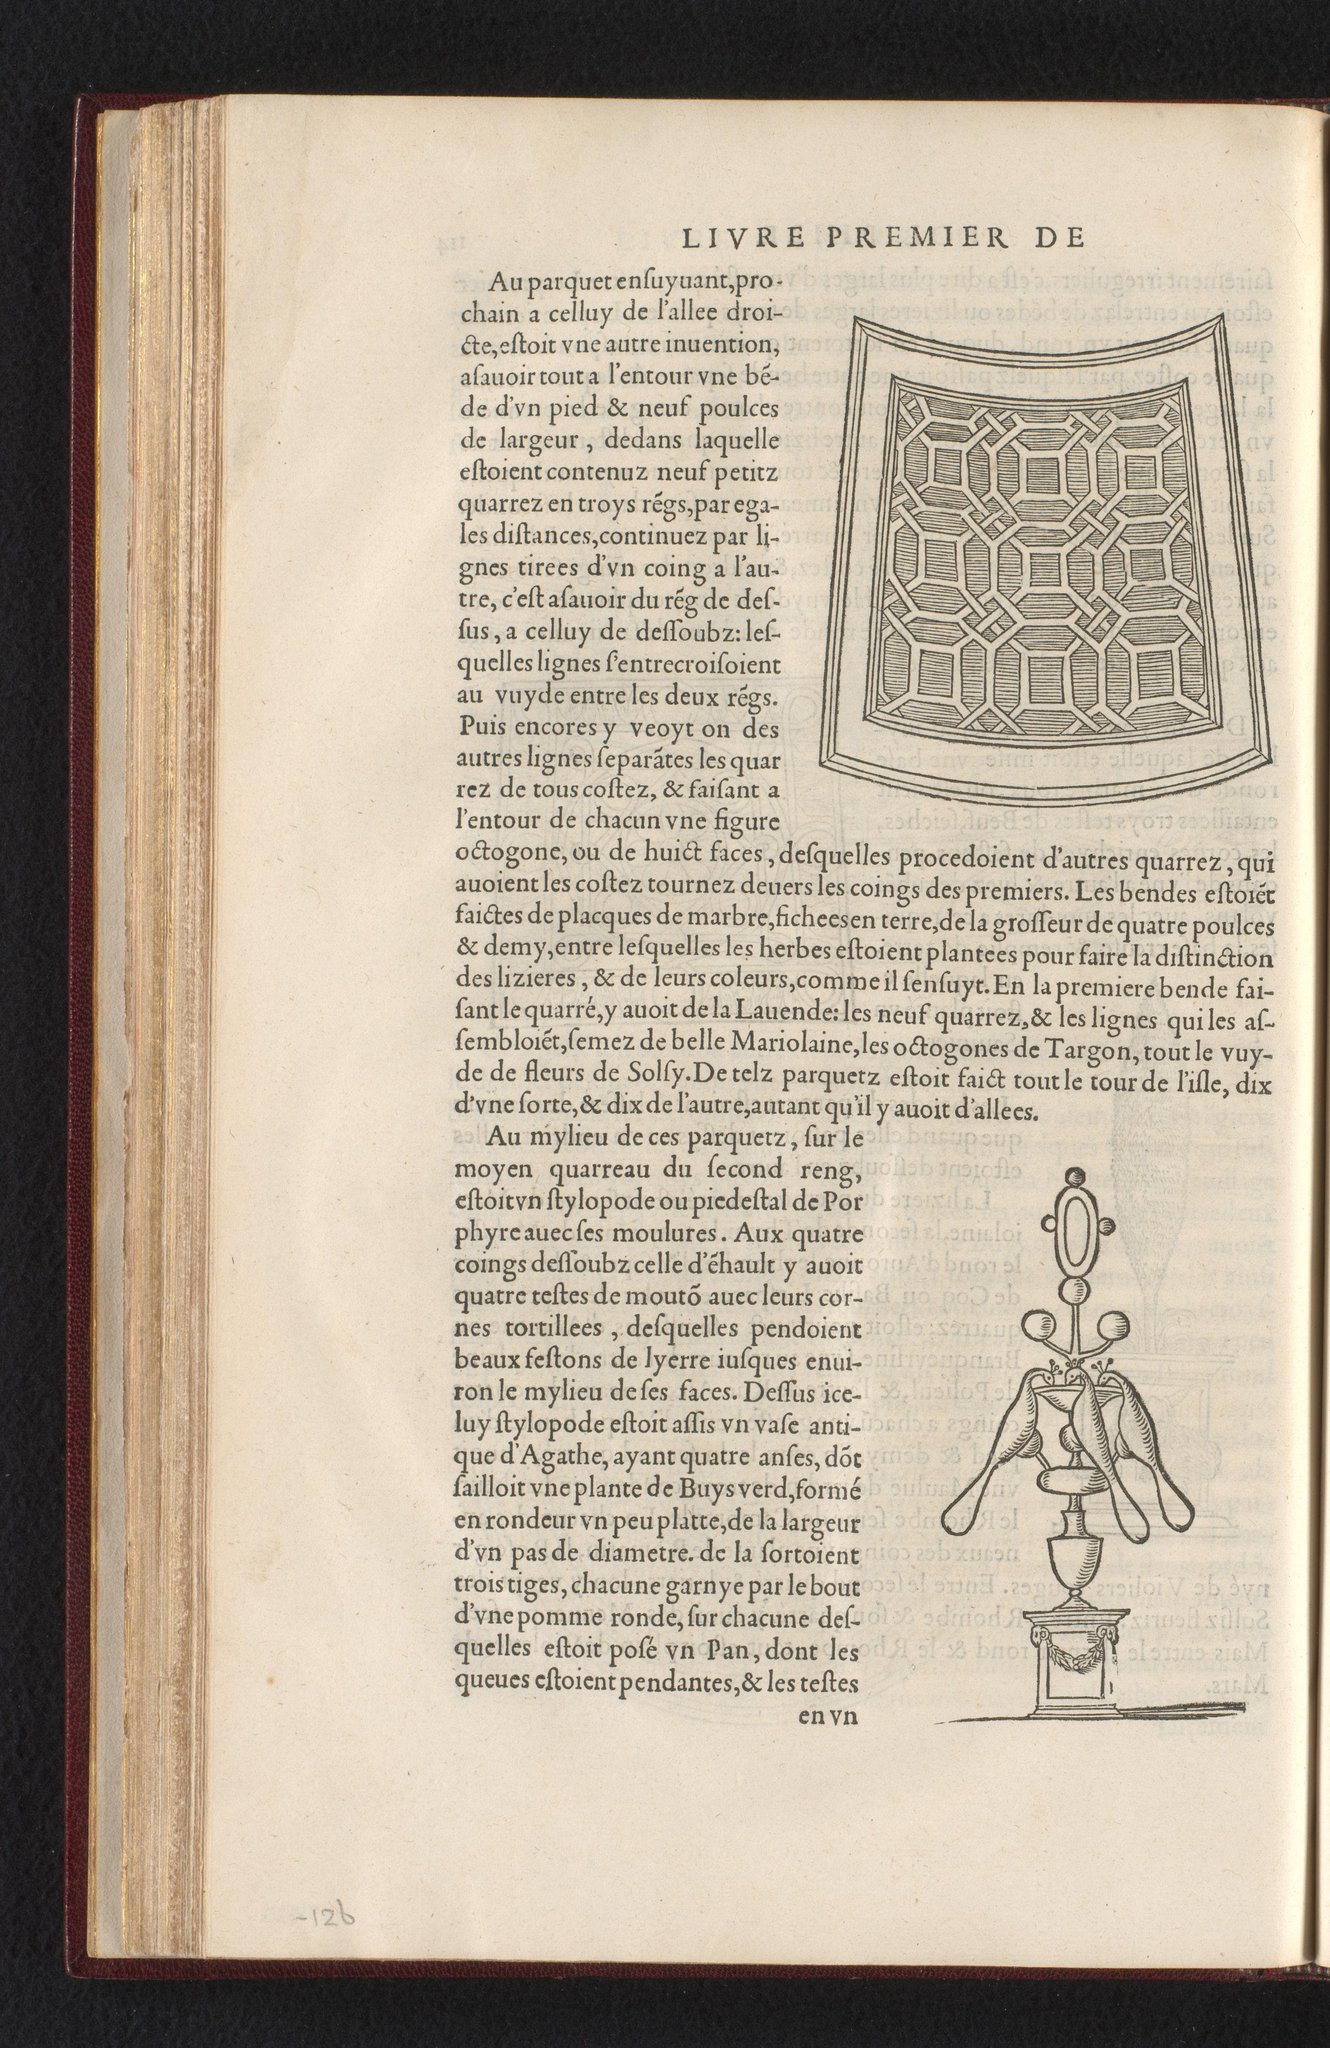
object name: page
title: Ontwerp voor een vloer en een fontein met pauwen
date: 1546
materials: paper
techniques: letterpress printing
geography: paris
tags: (scenes from) specific works of literature: colonna, hypnerotomachia poliphili, ornamental birds: peacock, ornamental fountain, pavement, floor ~ architecture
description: Prent uit: Colonna, Francesco. Hypnerotomachie ou discours du songe de Poliphile, deduisant comme amour le combat a l'occasion de Polia. Parijs: Jacques Kerver, 1546, verso fol. 114.